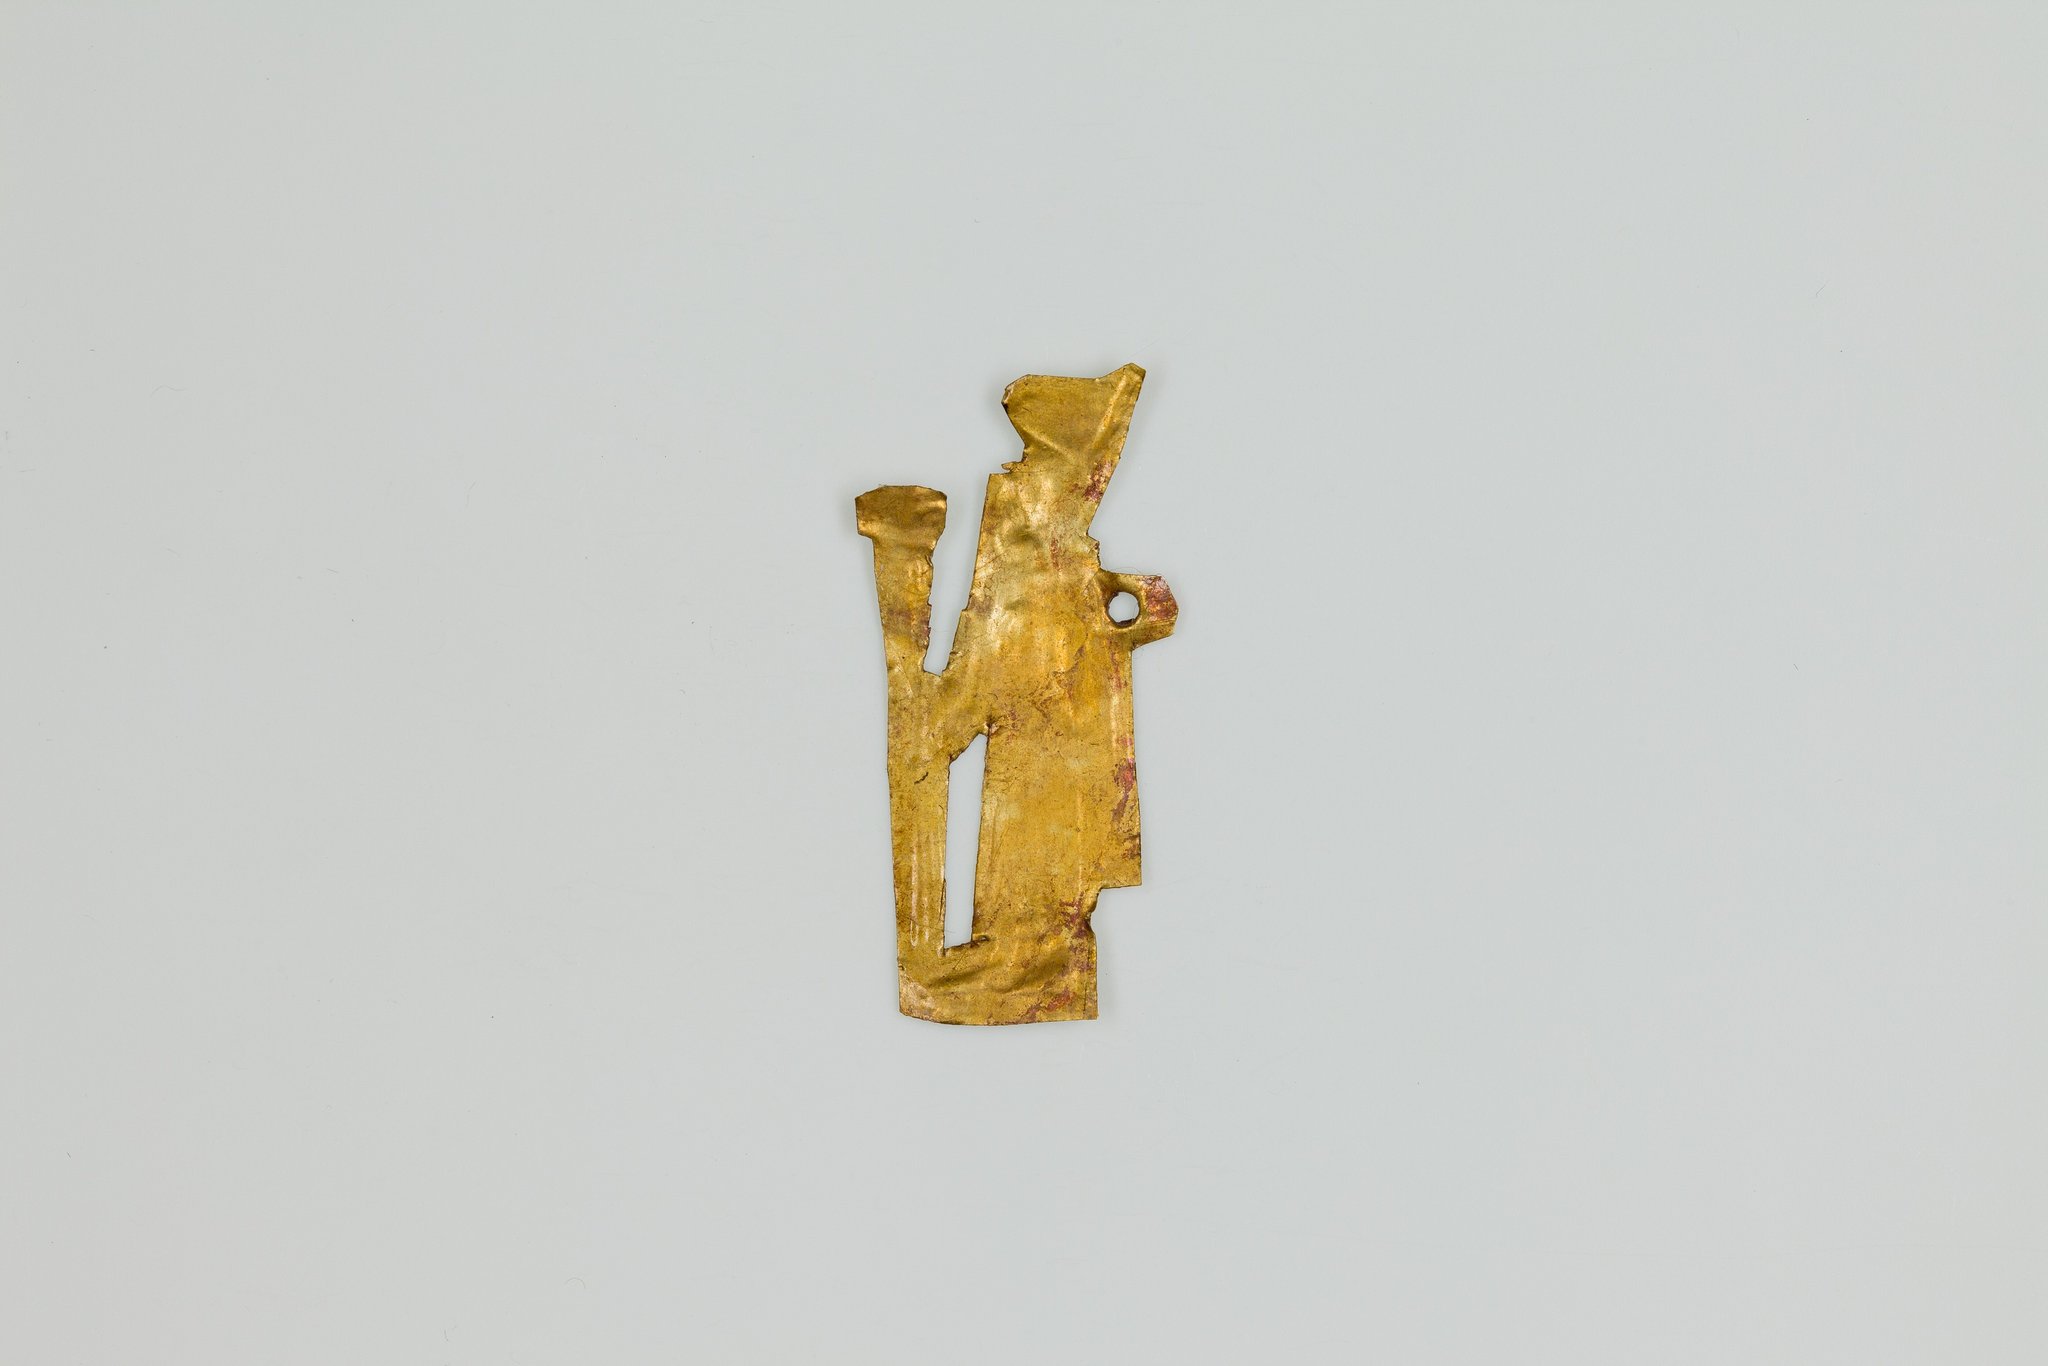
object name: amulet, neit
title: Neit (?) amulet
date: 664-380 BCE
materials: gold